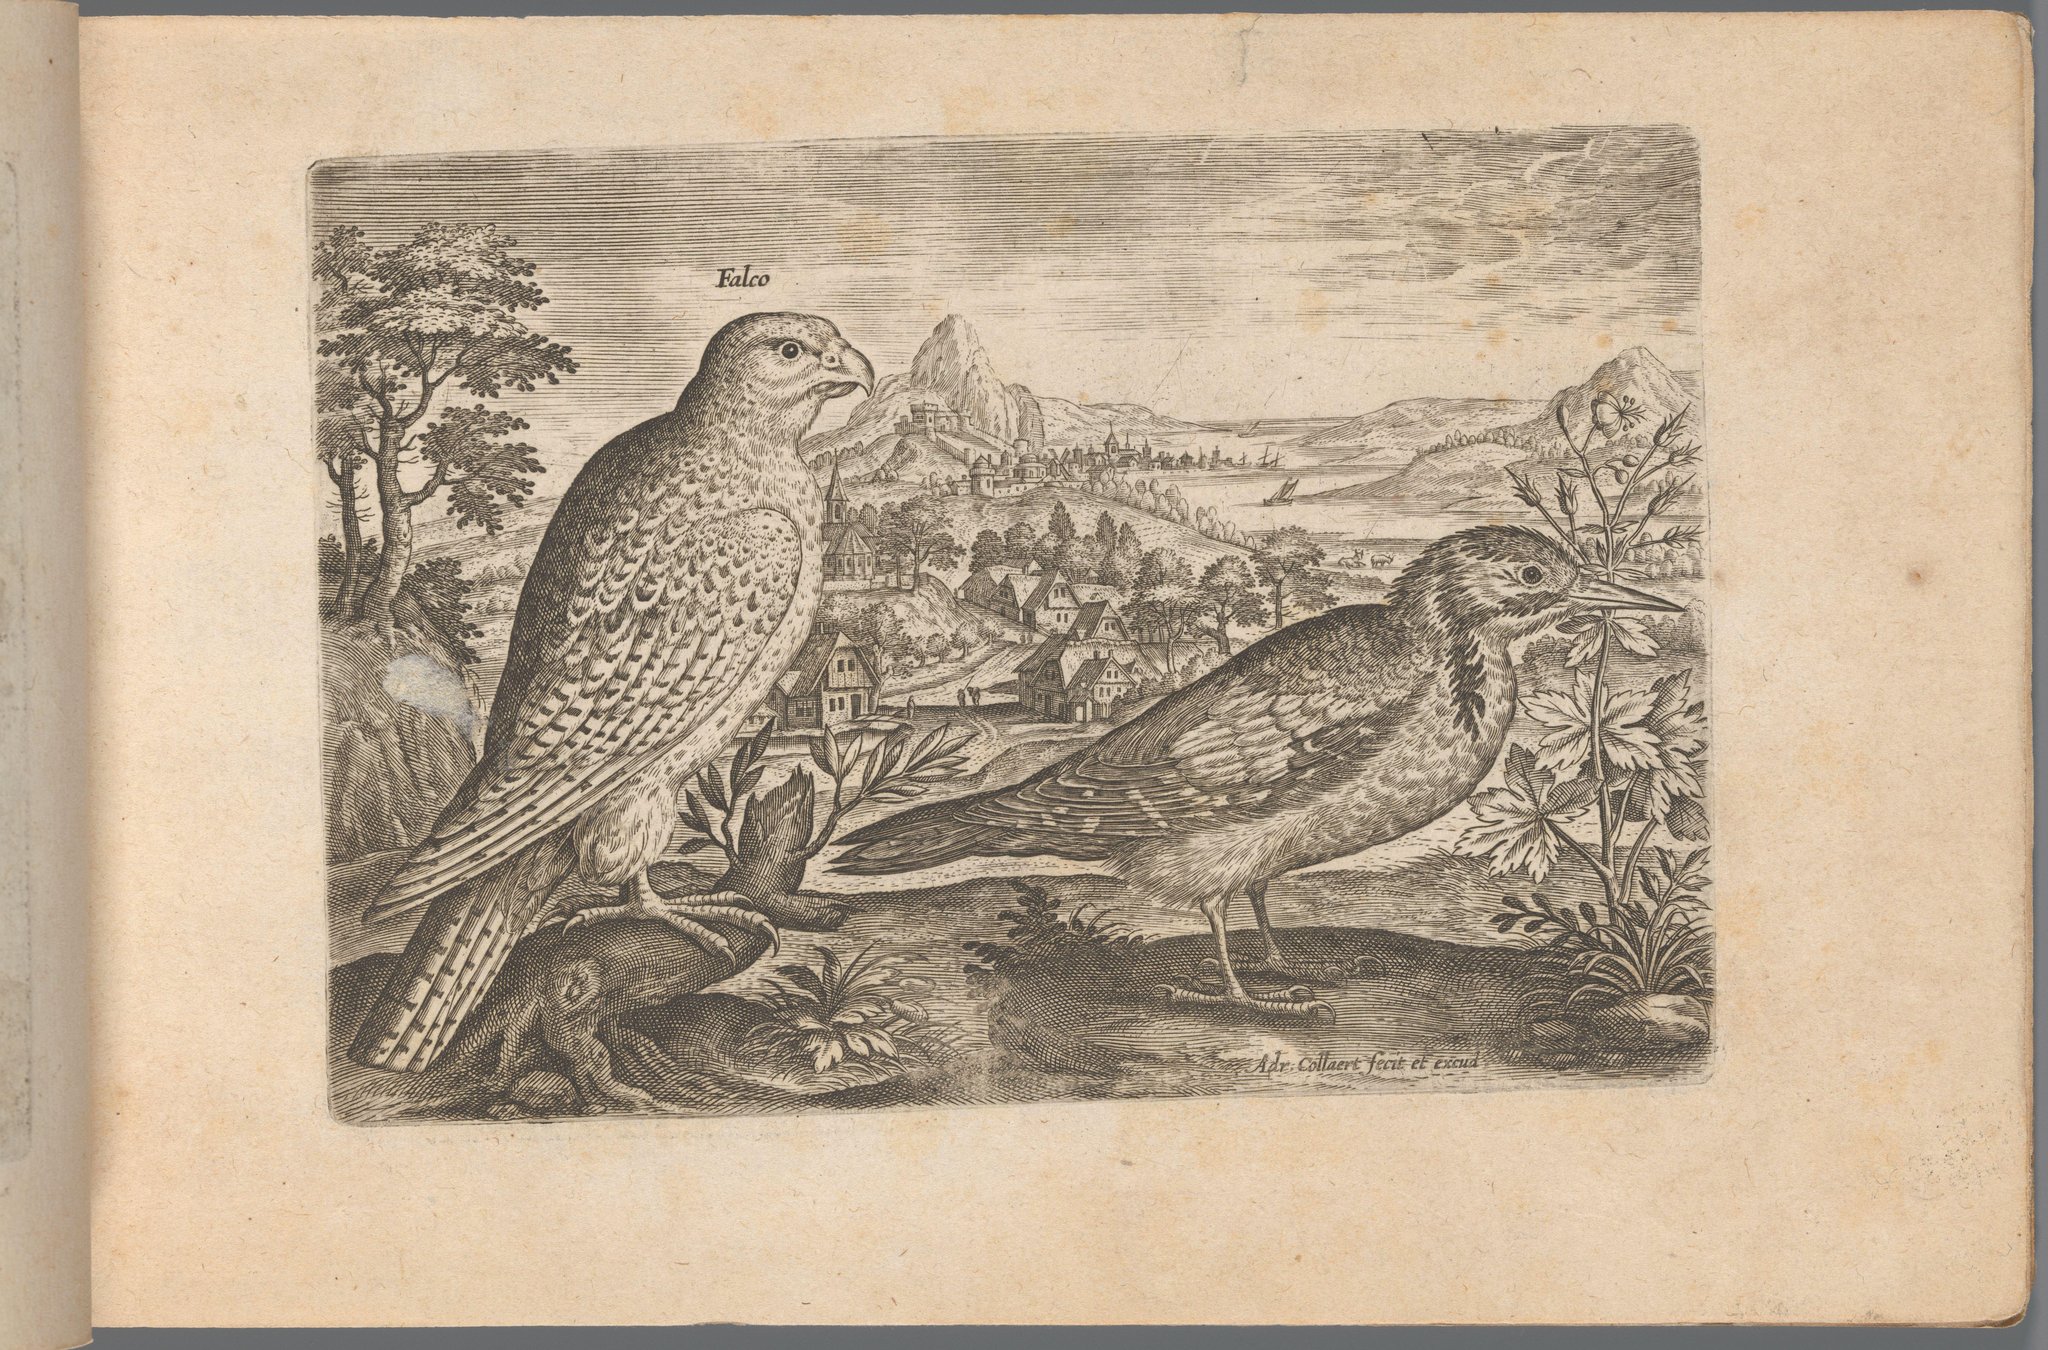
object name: print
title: Avium Vivae Icones in aes incisae & edita ab Adriano Collardo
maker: adriaen collaert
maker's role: draughtsman, print maker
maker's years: 1560-1618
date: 1570-1600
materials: paper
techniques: engraving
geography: antwerp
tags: predatory birds: falcon, other birds: woodpecker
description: Een torenvalk en een grijze bonte specht in een landschap. Prent is onderdeel van een prentalbum met zeven prenten van vogels en de titelprent.